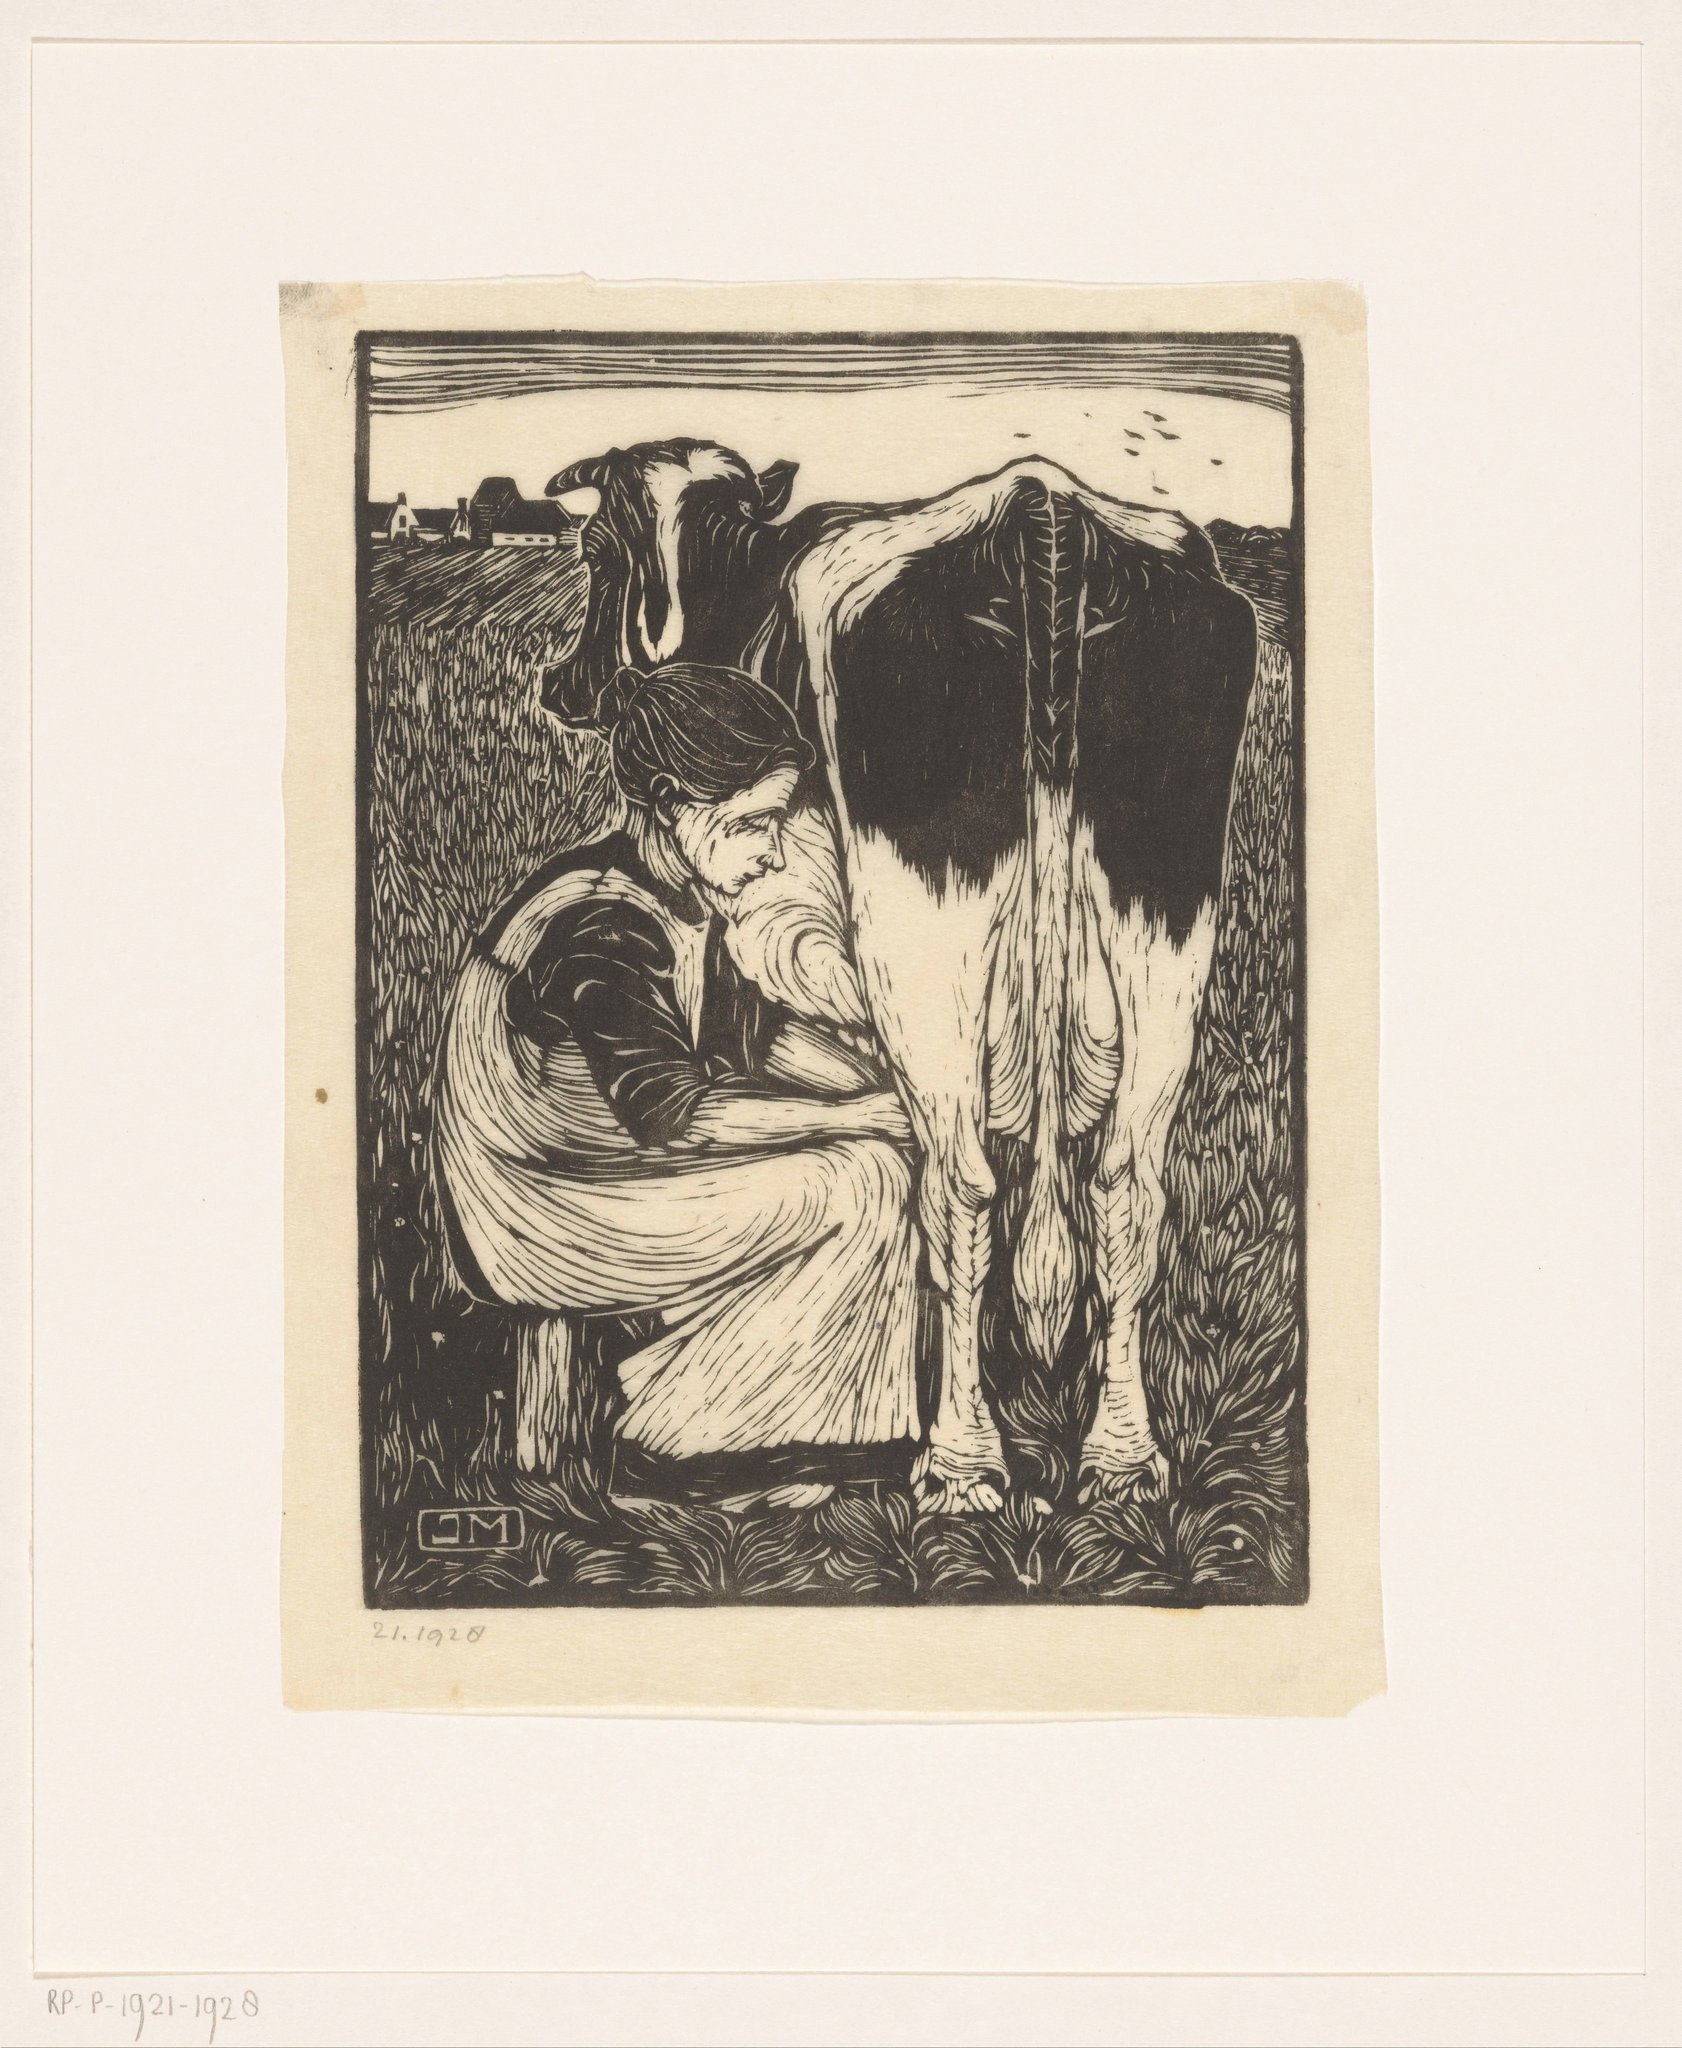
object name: print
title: Koemelkster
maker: jan mankes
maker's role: draughtsman, painter, print maker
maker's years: 1889-1920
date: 1914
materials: paper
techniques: woodcut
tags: cow, adult woman, milking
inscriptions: collector's mark: Lugt 2228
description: Een vrouw zit op een kruk in een weiland een koe te melken.